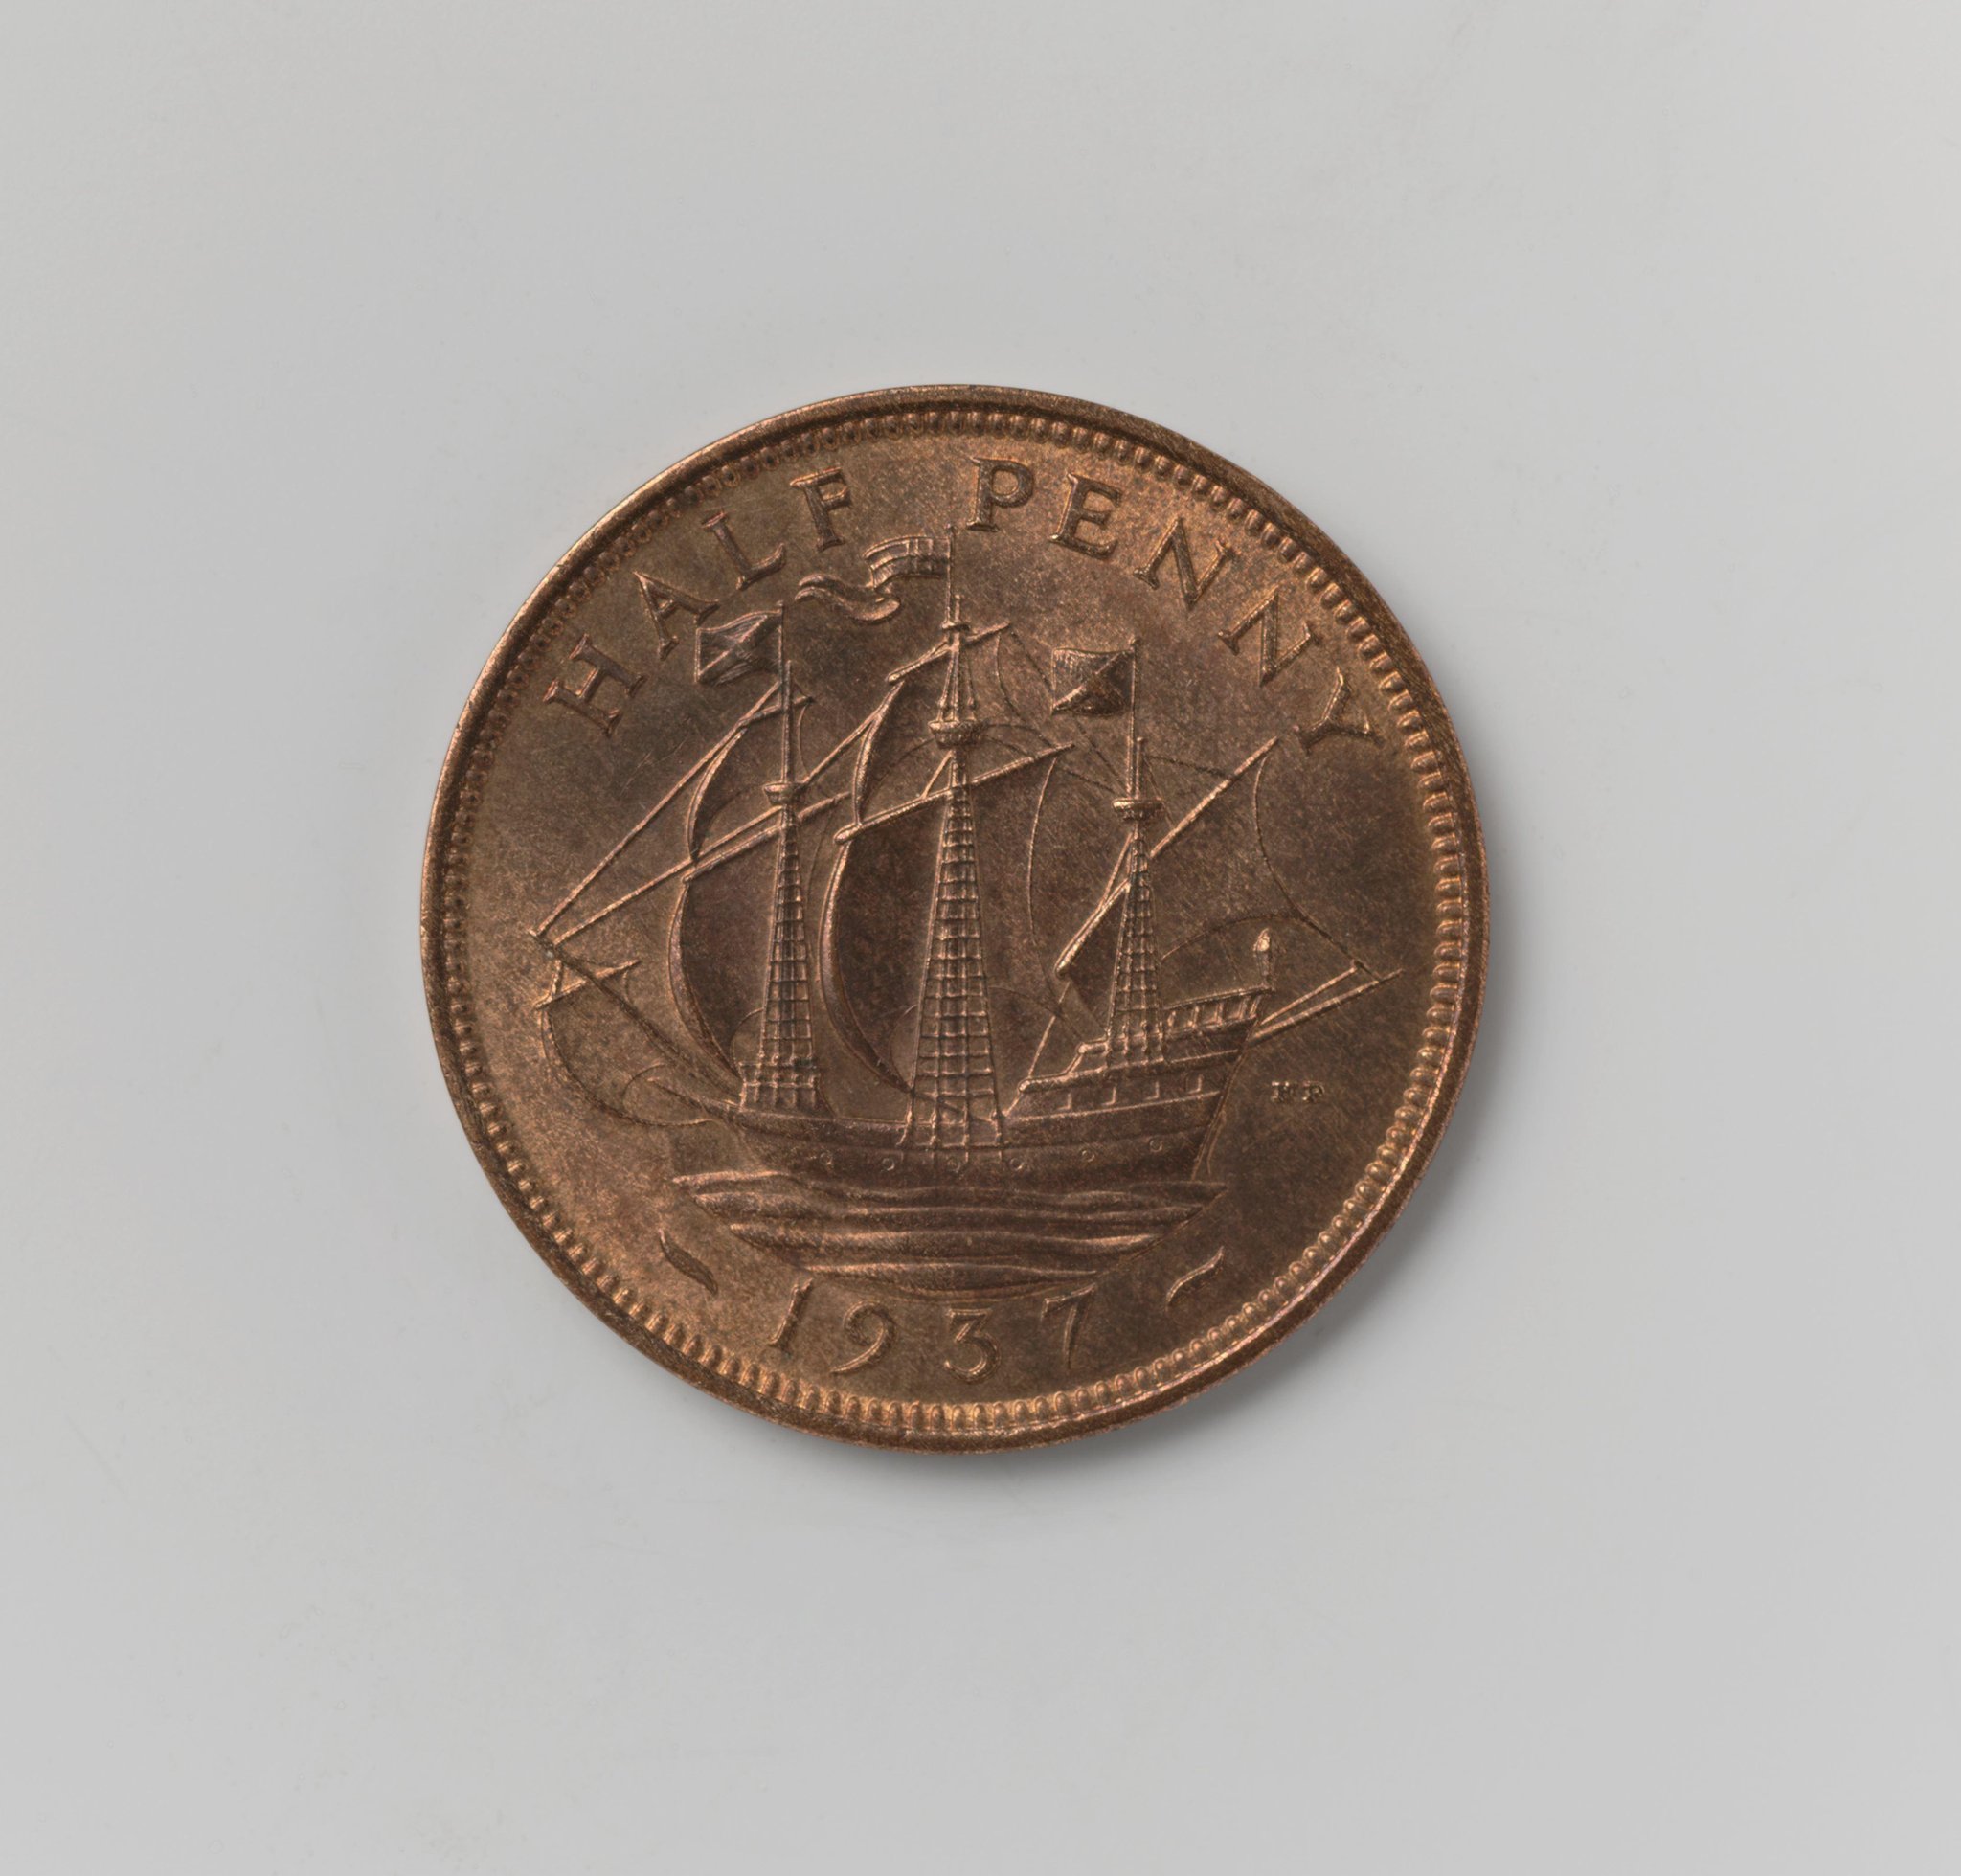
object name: halve penny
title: ½ penny uit Engeland van George VI, 1937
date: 1937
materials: bronze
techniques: striking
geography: london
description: Bronzen munt. Voorzijde:gekroond borstbeeld van de koning naar links. Keerzijde: op zee met volle zeilen varend schip, naar links. Daaronder jaartal. Daarboven waarde-aanduiding als omschrift. Gladde rand.